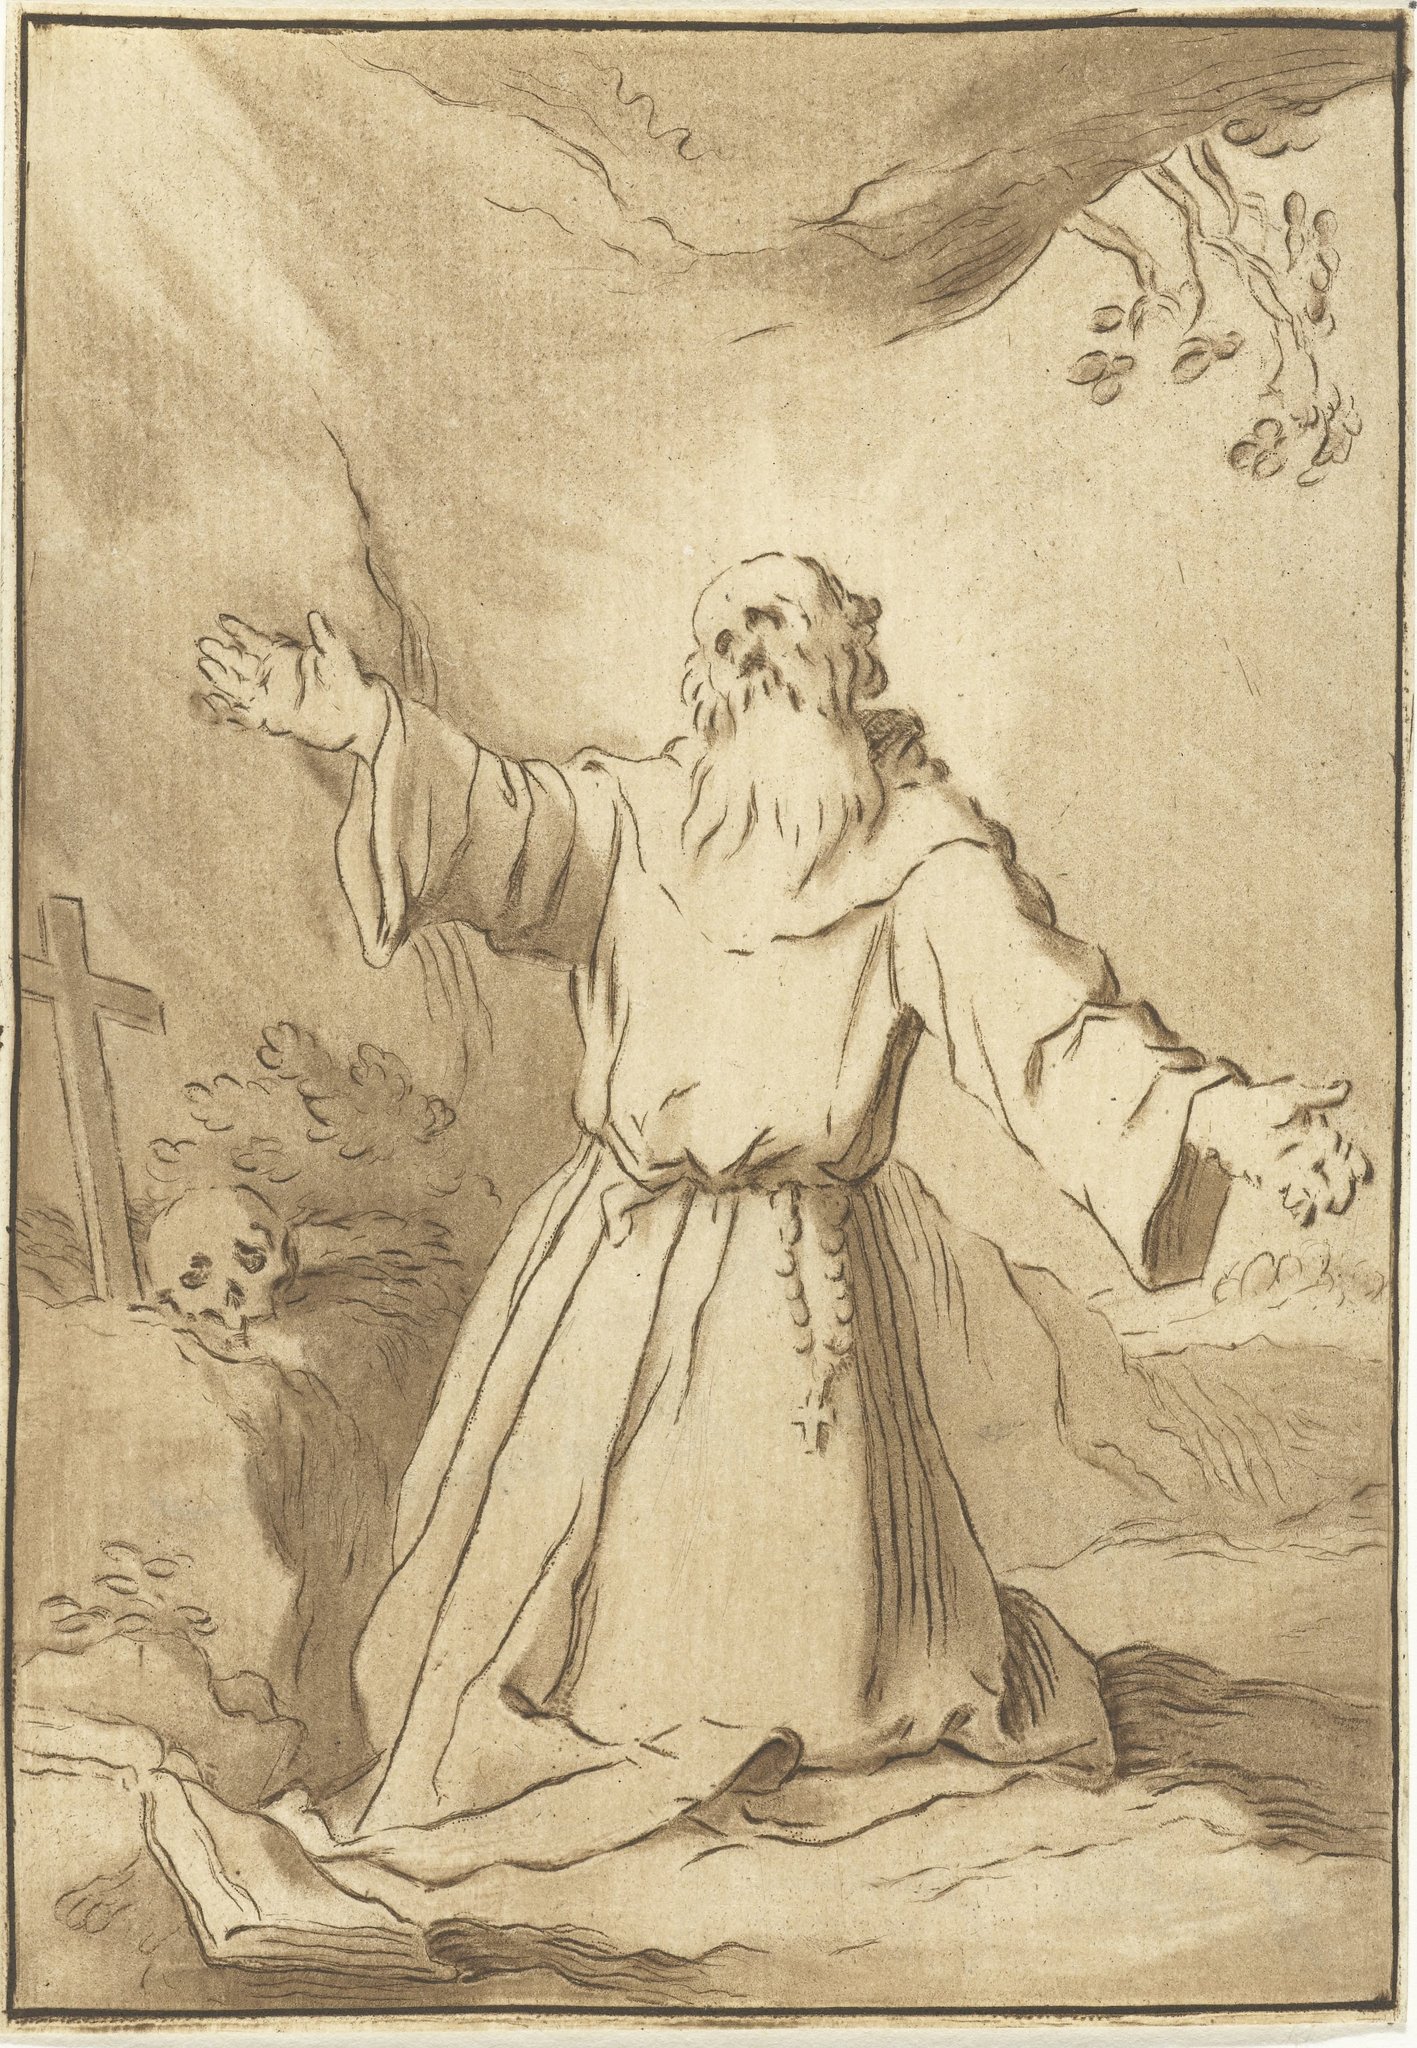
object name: print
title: Heilige Franciscus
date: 1724-1798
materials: paper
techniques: print drawing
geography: amsterdam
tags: founder of the order of friars minor (franciscans), francis(cus) of assisi; possible attributes: book, crucifix, lily, skull, stigmata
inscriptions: collector's mark: Lugt 2228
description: De heilige Franciscus, geknield voor een kruis.